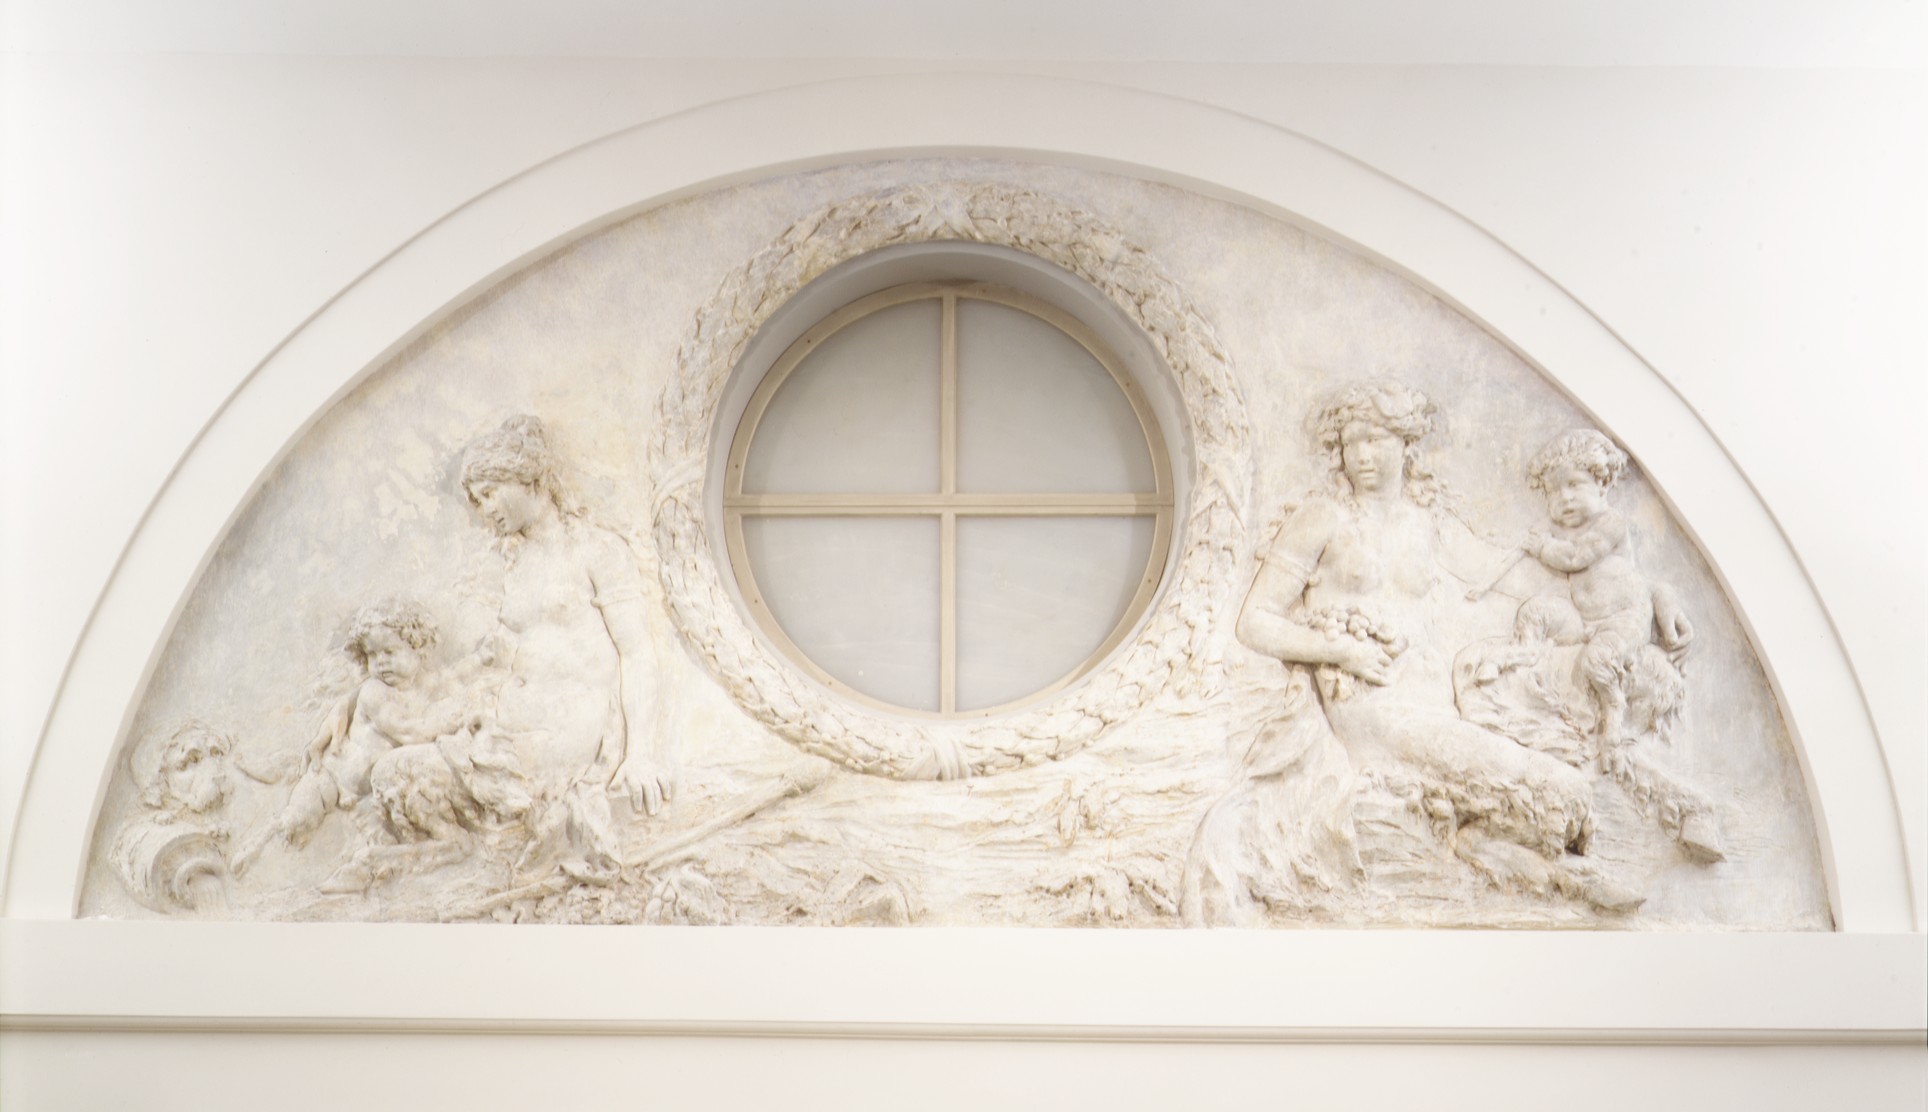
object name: relief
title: Satyresses and satyr children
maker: clodion (claude michel)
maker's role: artist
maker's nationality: french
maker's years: 1738-1814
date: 1781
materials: plaster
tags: infants,satyrs